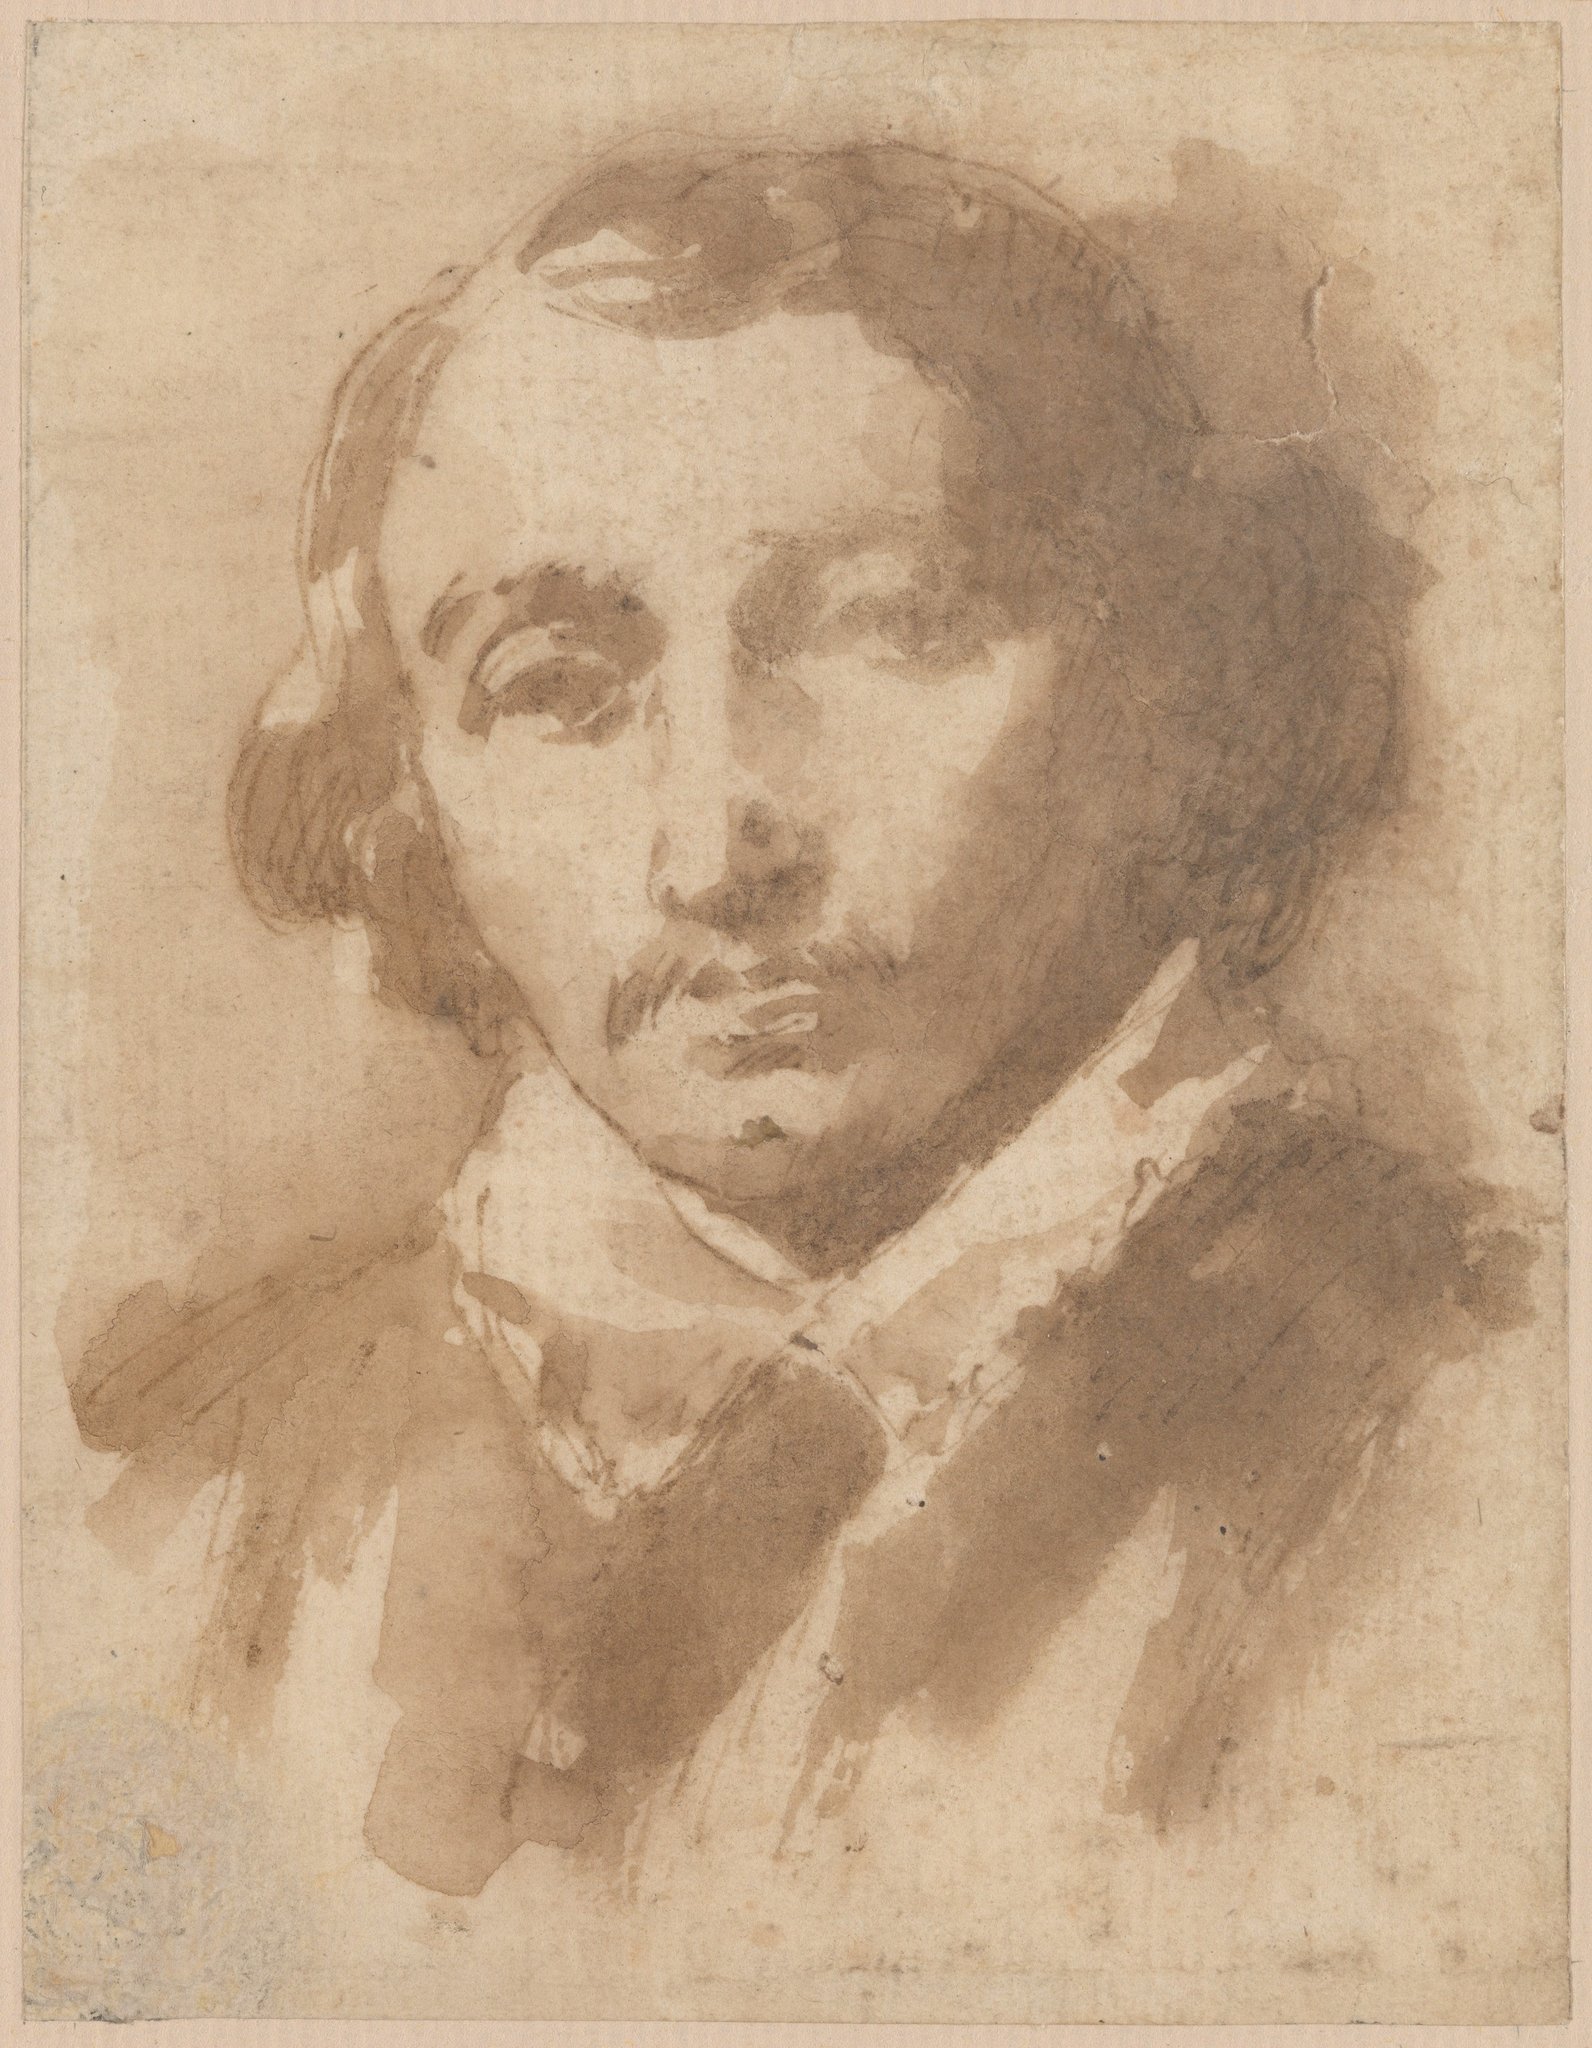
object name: drawing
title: Portrait of a man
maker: anonymous, italian, 19th century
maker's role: artist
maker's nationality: italian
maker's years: 1800-1900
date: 1801-1900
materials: ink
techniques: pen, wash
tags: men,portraits